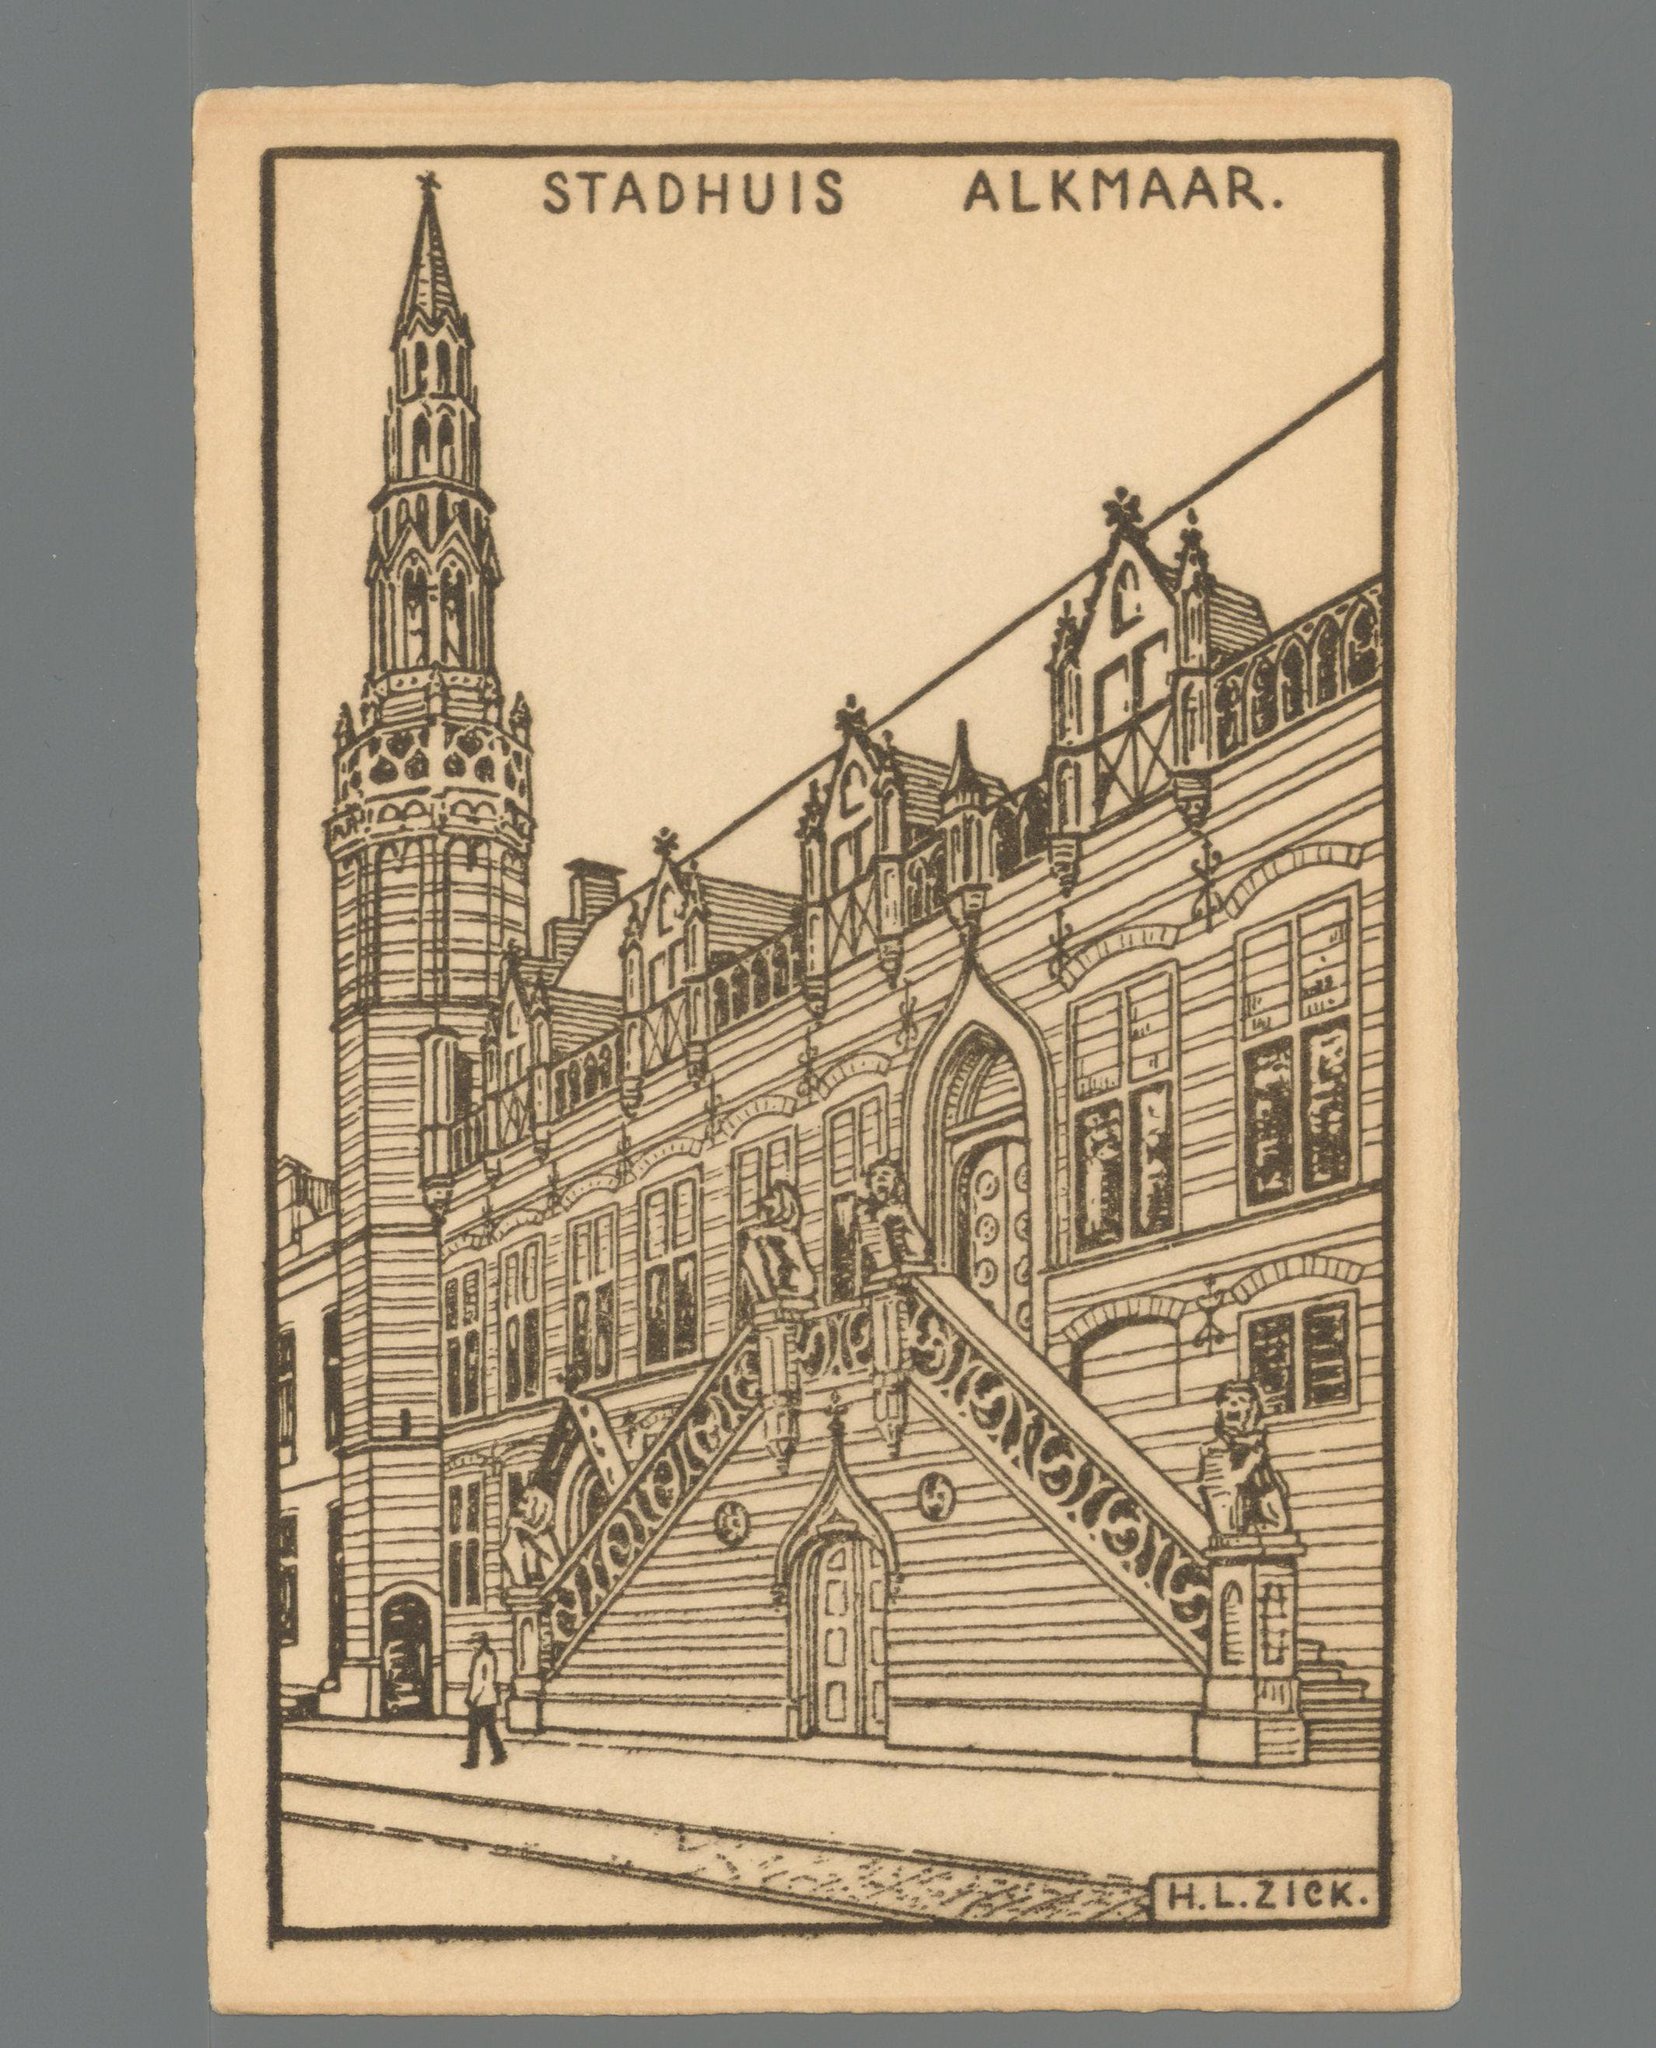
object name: ansichtkaart, prentbriefkaart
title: Stadhuis, Alkmaar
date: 1905-1940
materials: cardboard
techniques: printing block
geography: alkmaar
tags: townhall